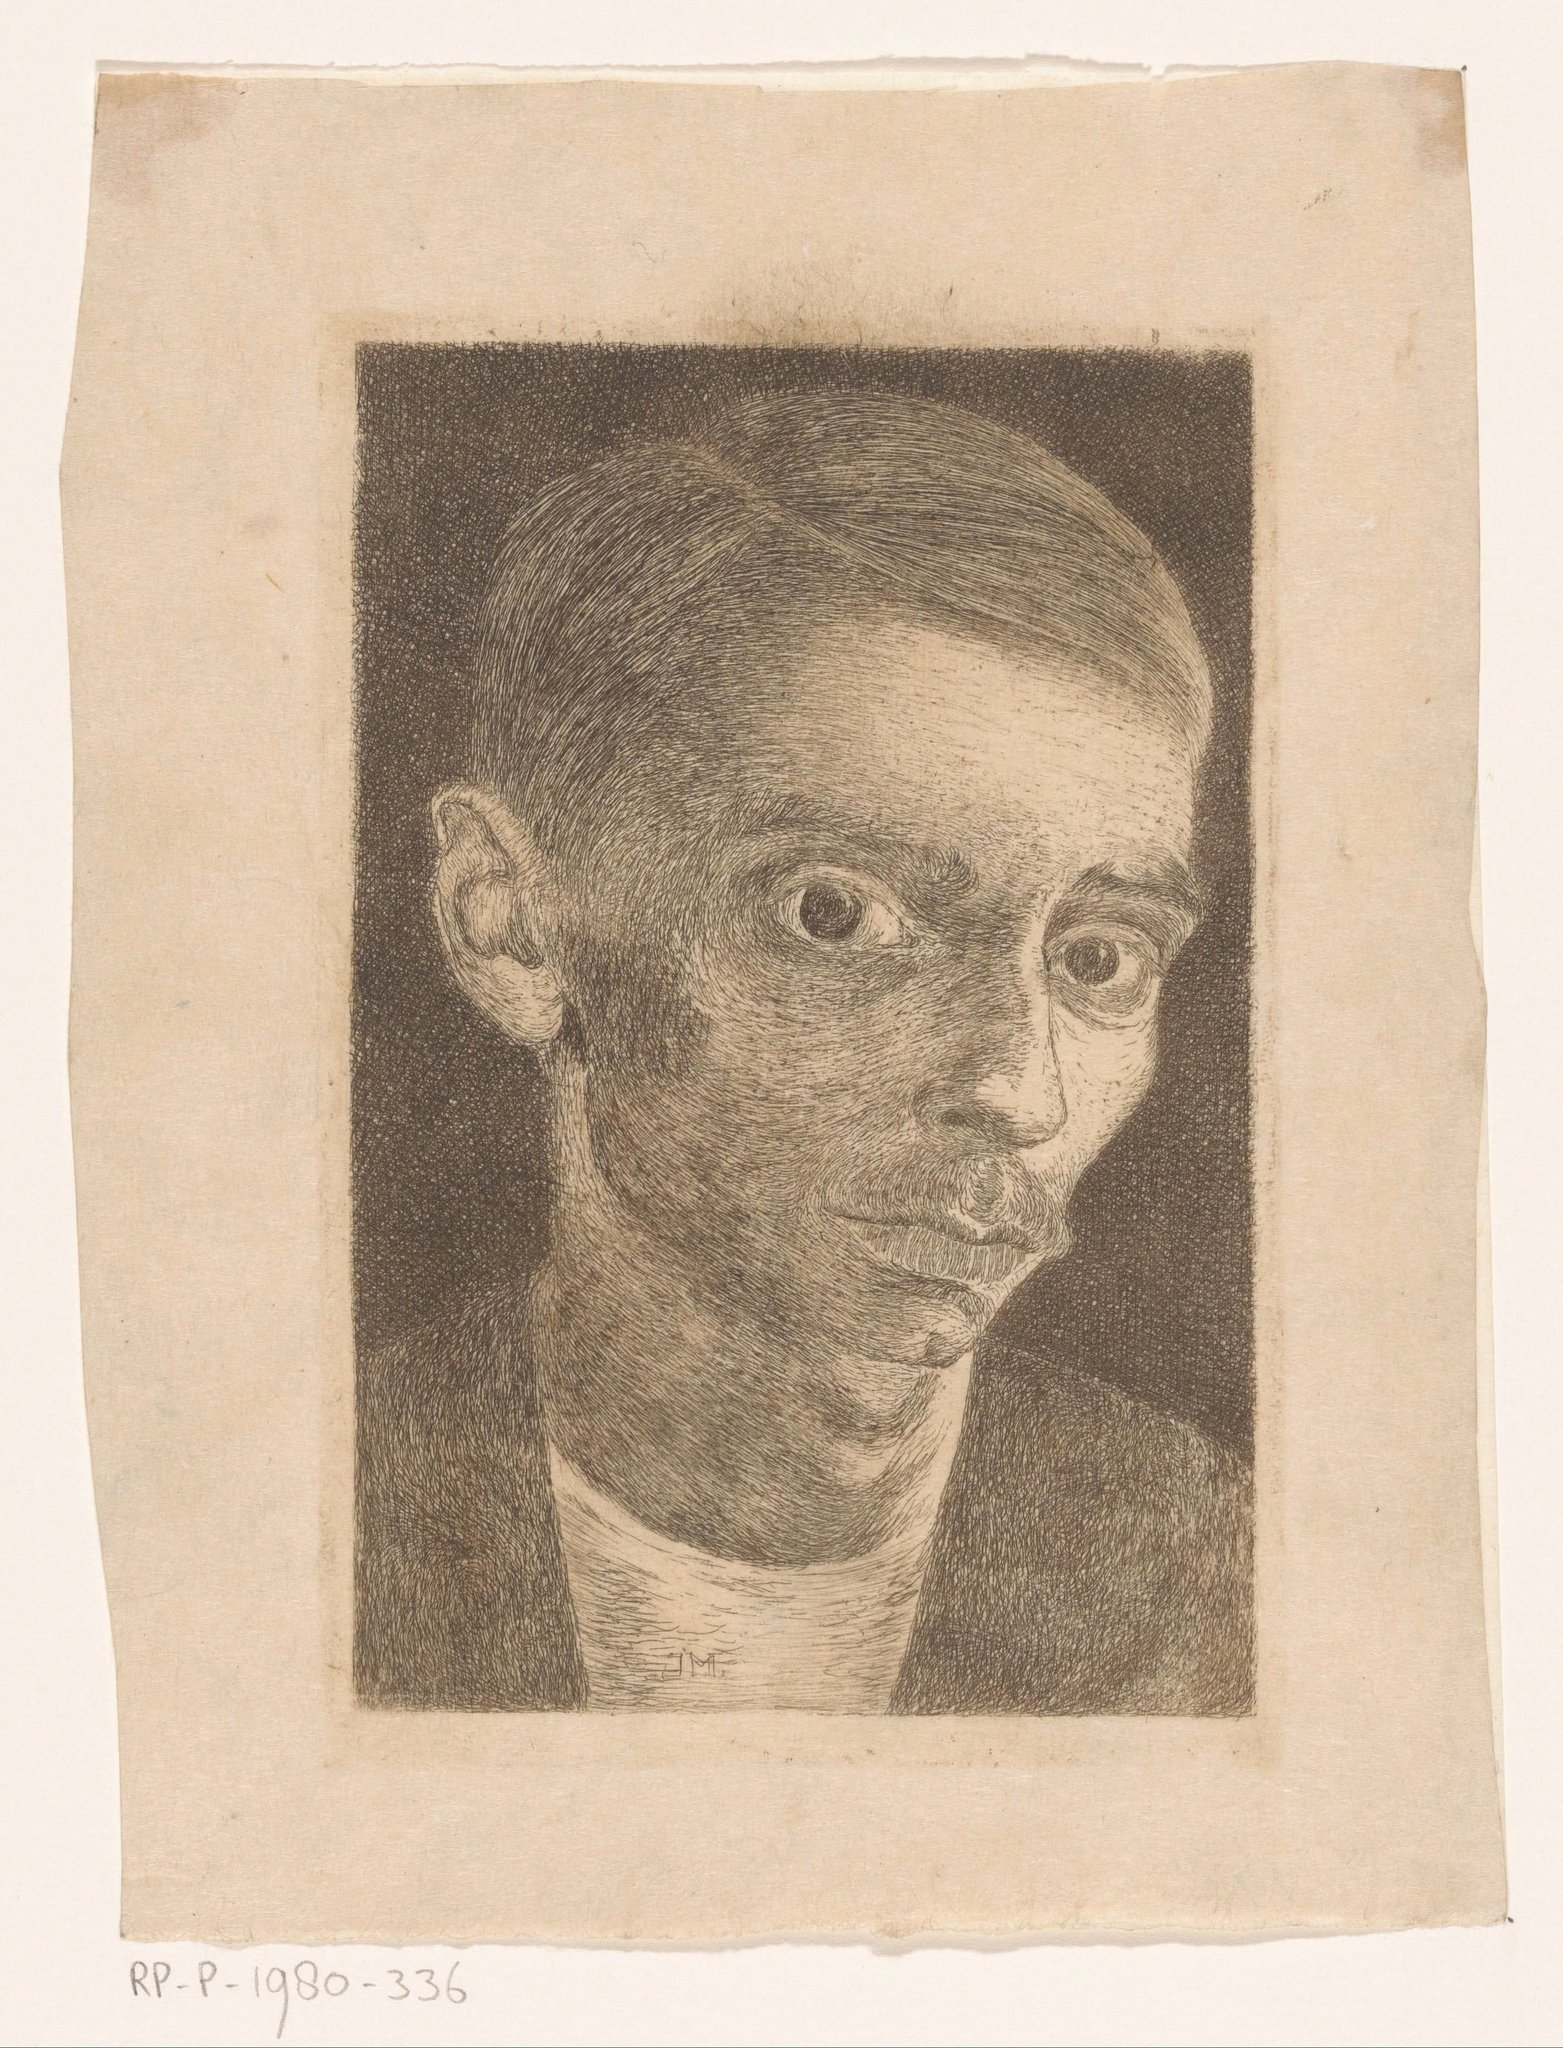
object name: print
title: Zelfportret met snor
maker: jan mankes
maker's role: draughtsman, painter, print maker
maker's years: 1889-1920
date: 1915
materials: paper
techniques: etching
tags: painter, jan mankes, portrait, self-portrait of artist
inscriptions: collector's mark: Lugt 2228